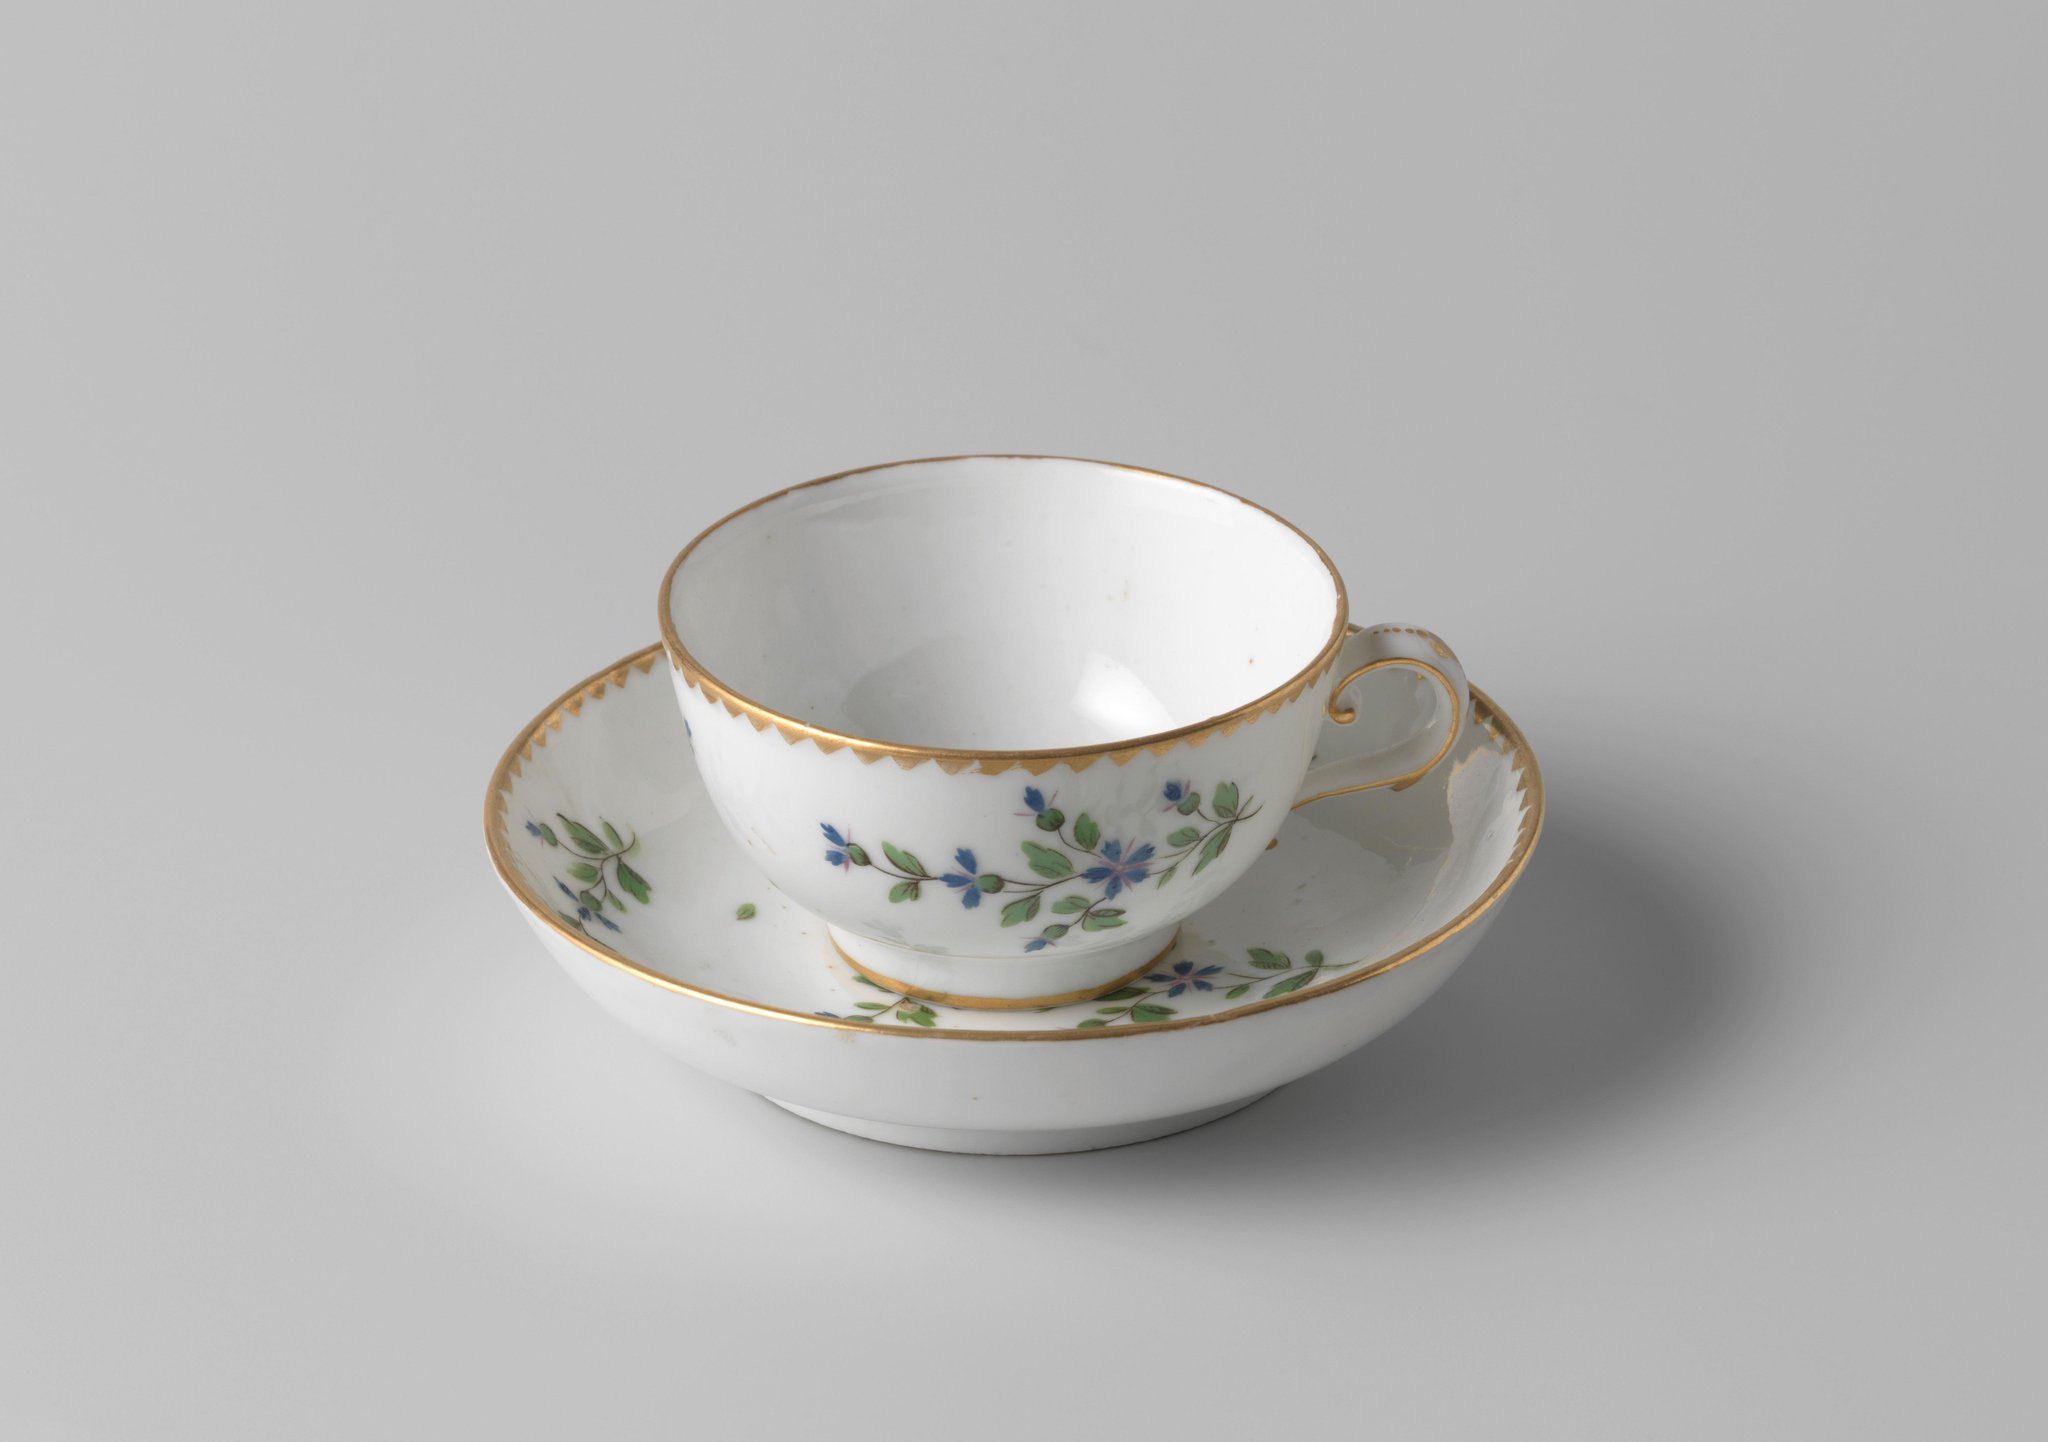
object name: platter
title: Saucer with flower sprays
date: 1790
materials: glaze, gold, paint, porcelain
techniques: firing, forming, gilding, turning, vitrification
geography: lille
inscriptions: mark: ‘gekroonde dolfijn’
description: Schotel van porselein, beschilderd op het glazuur in blauw, roze, groen, zwart en goud. Op het plat een bloemtak (korenbloem) omgeven door drie dezelfde bloemtakken op de wand. Een band met gouden driehoeken op de rand. Gemerkt op de onderzijde met de gekroonde dolfijn.